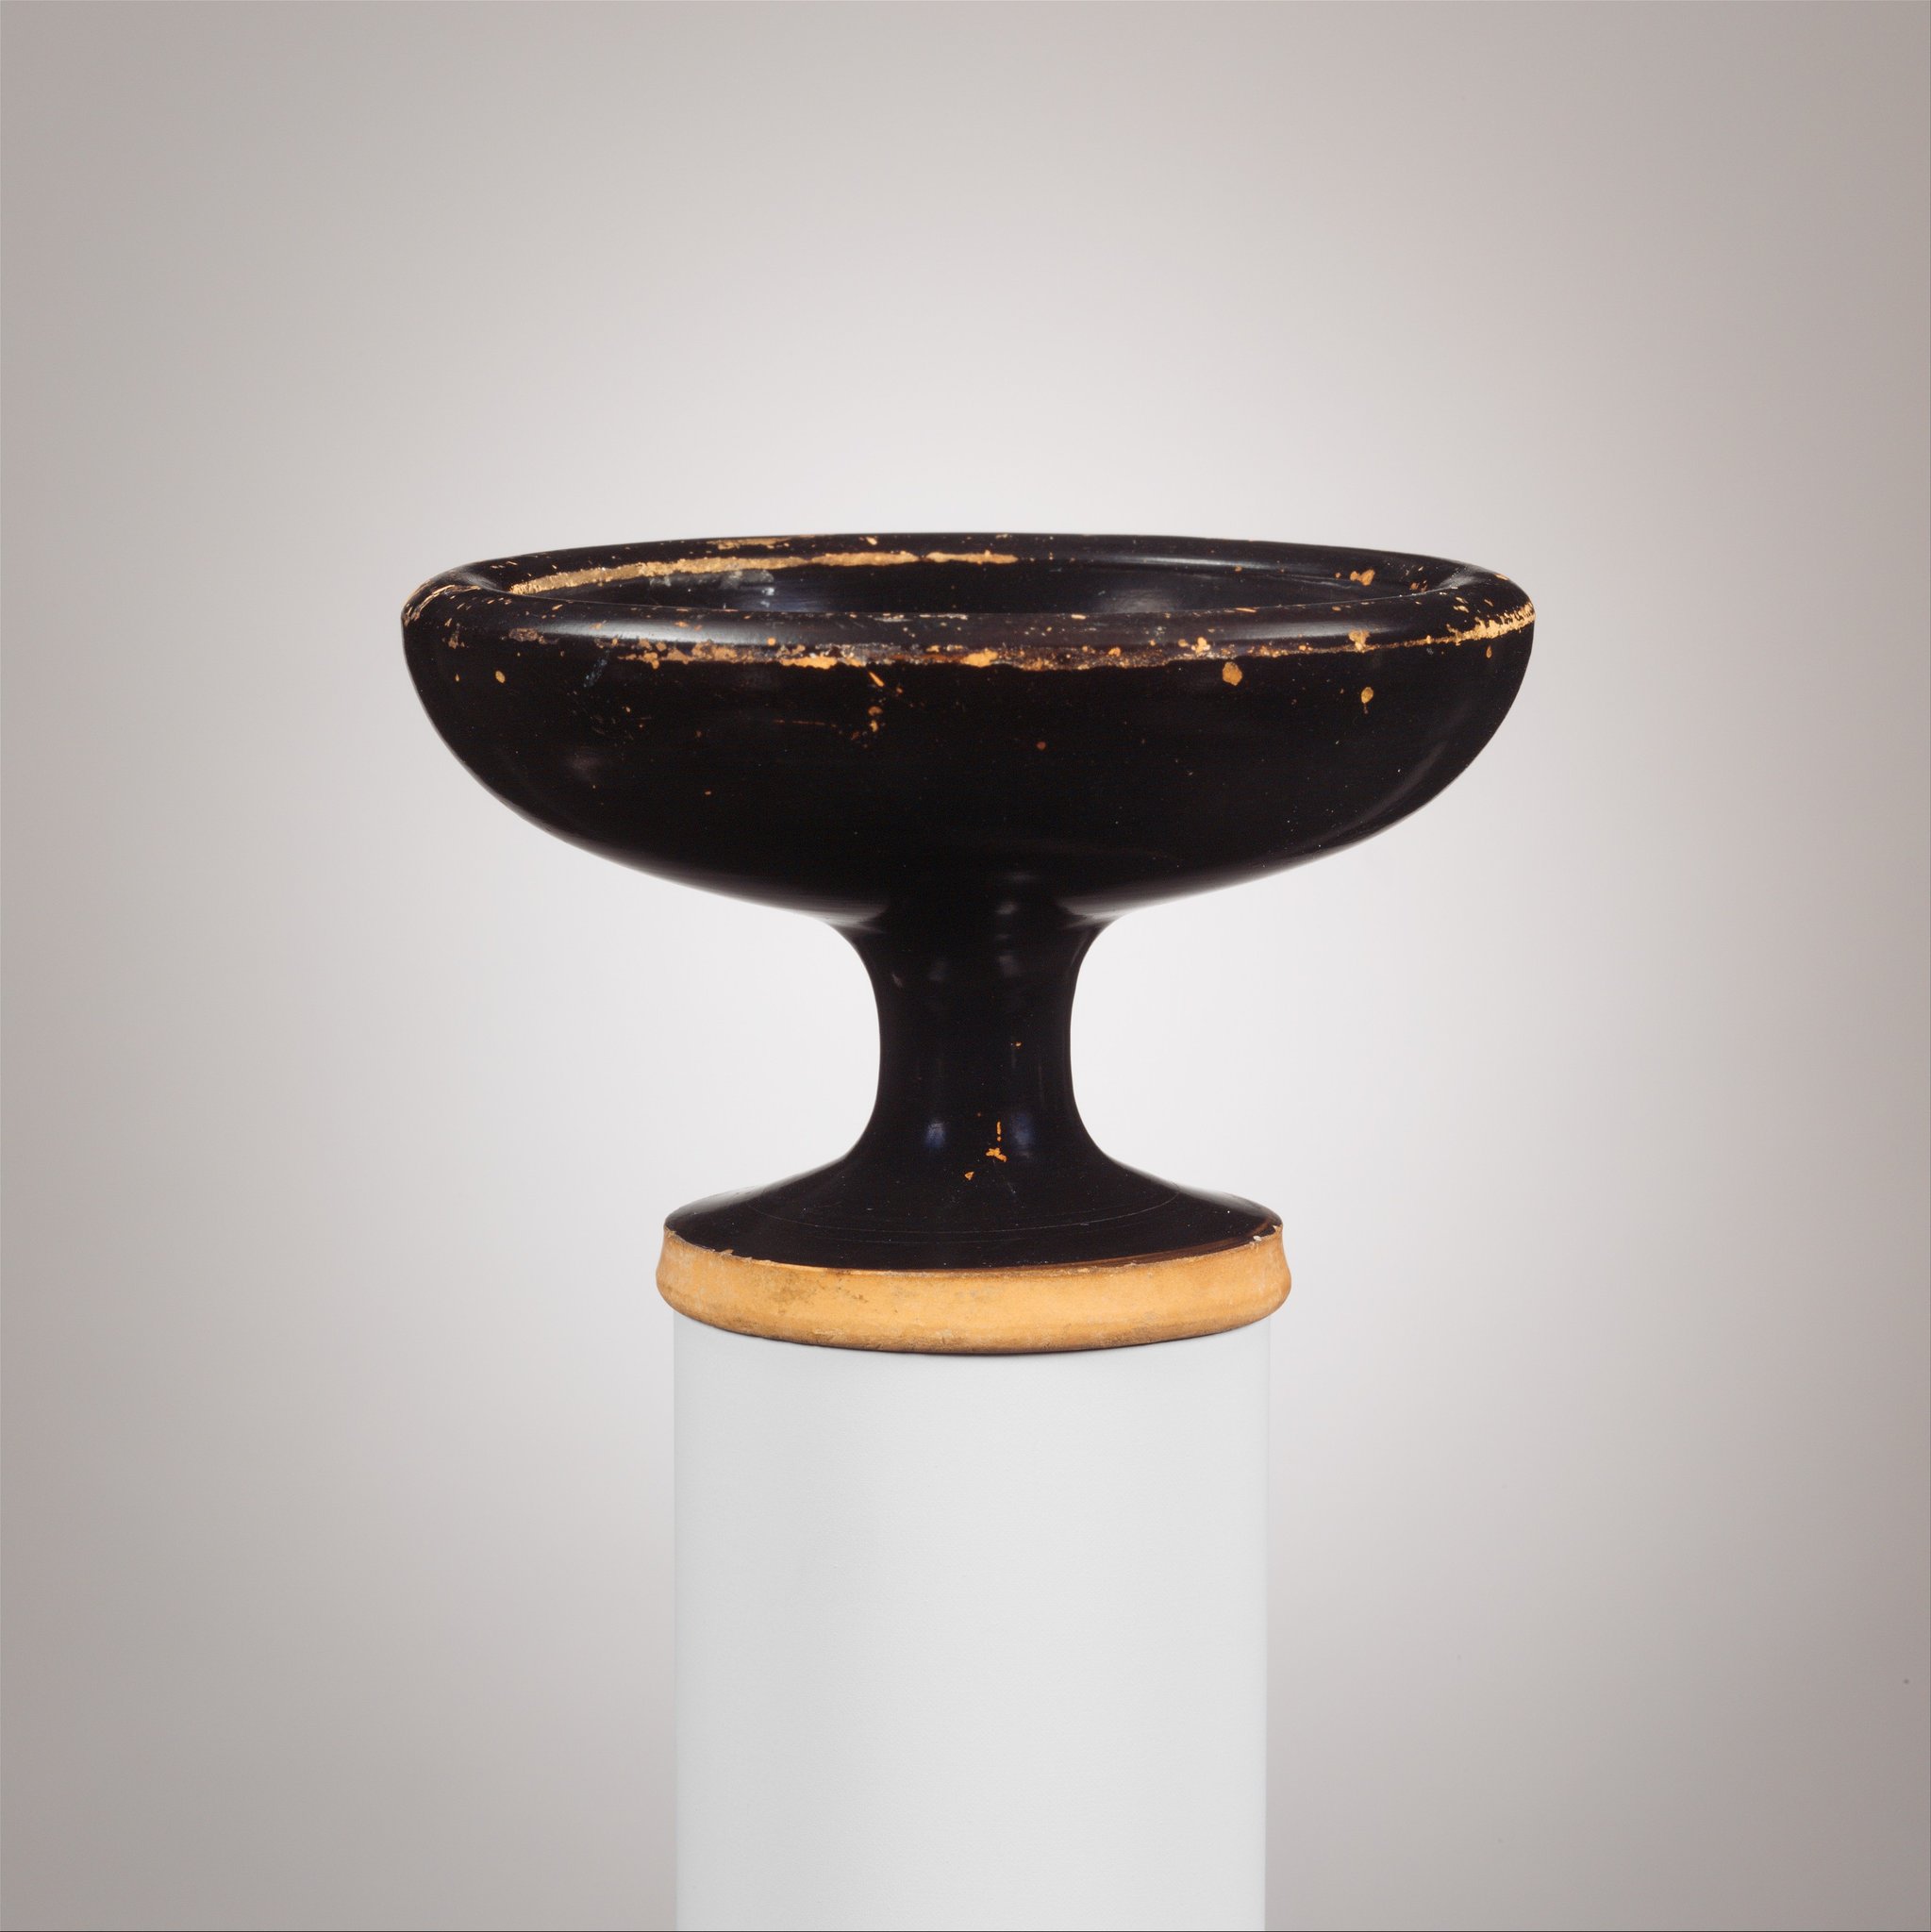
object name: stemmed dish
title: Terracotta stemmed dish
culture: greek, attic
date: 600-401 BCE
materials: terracotta